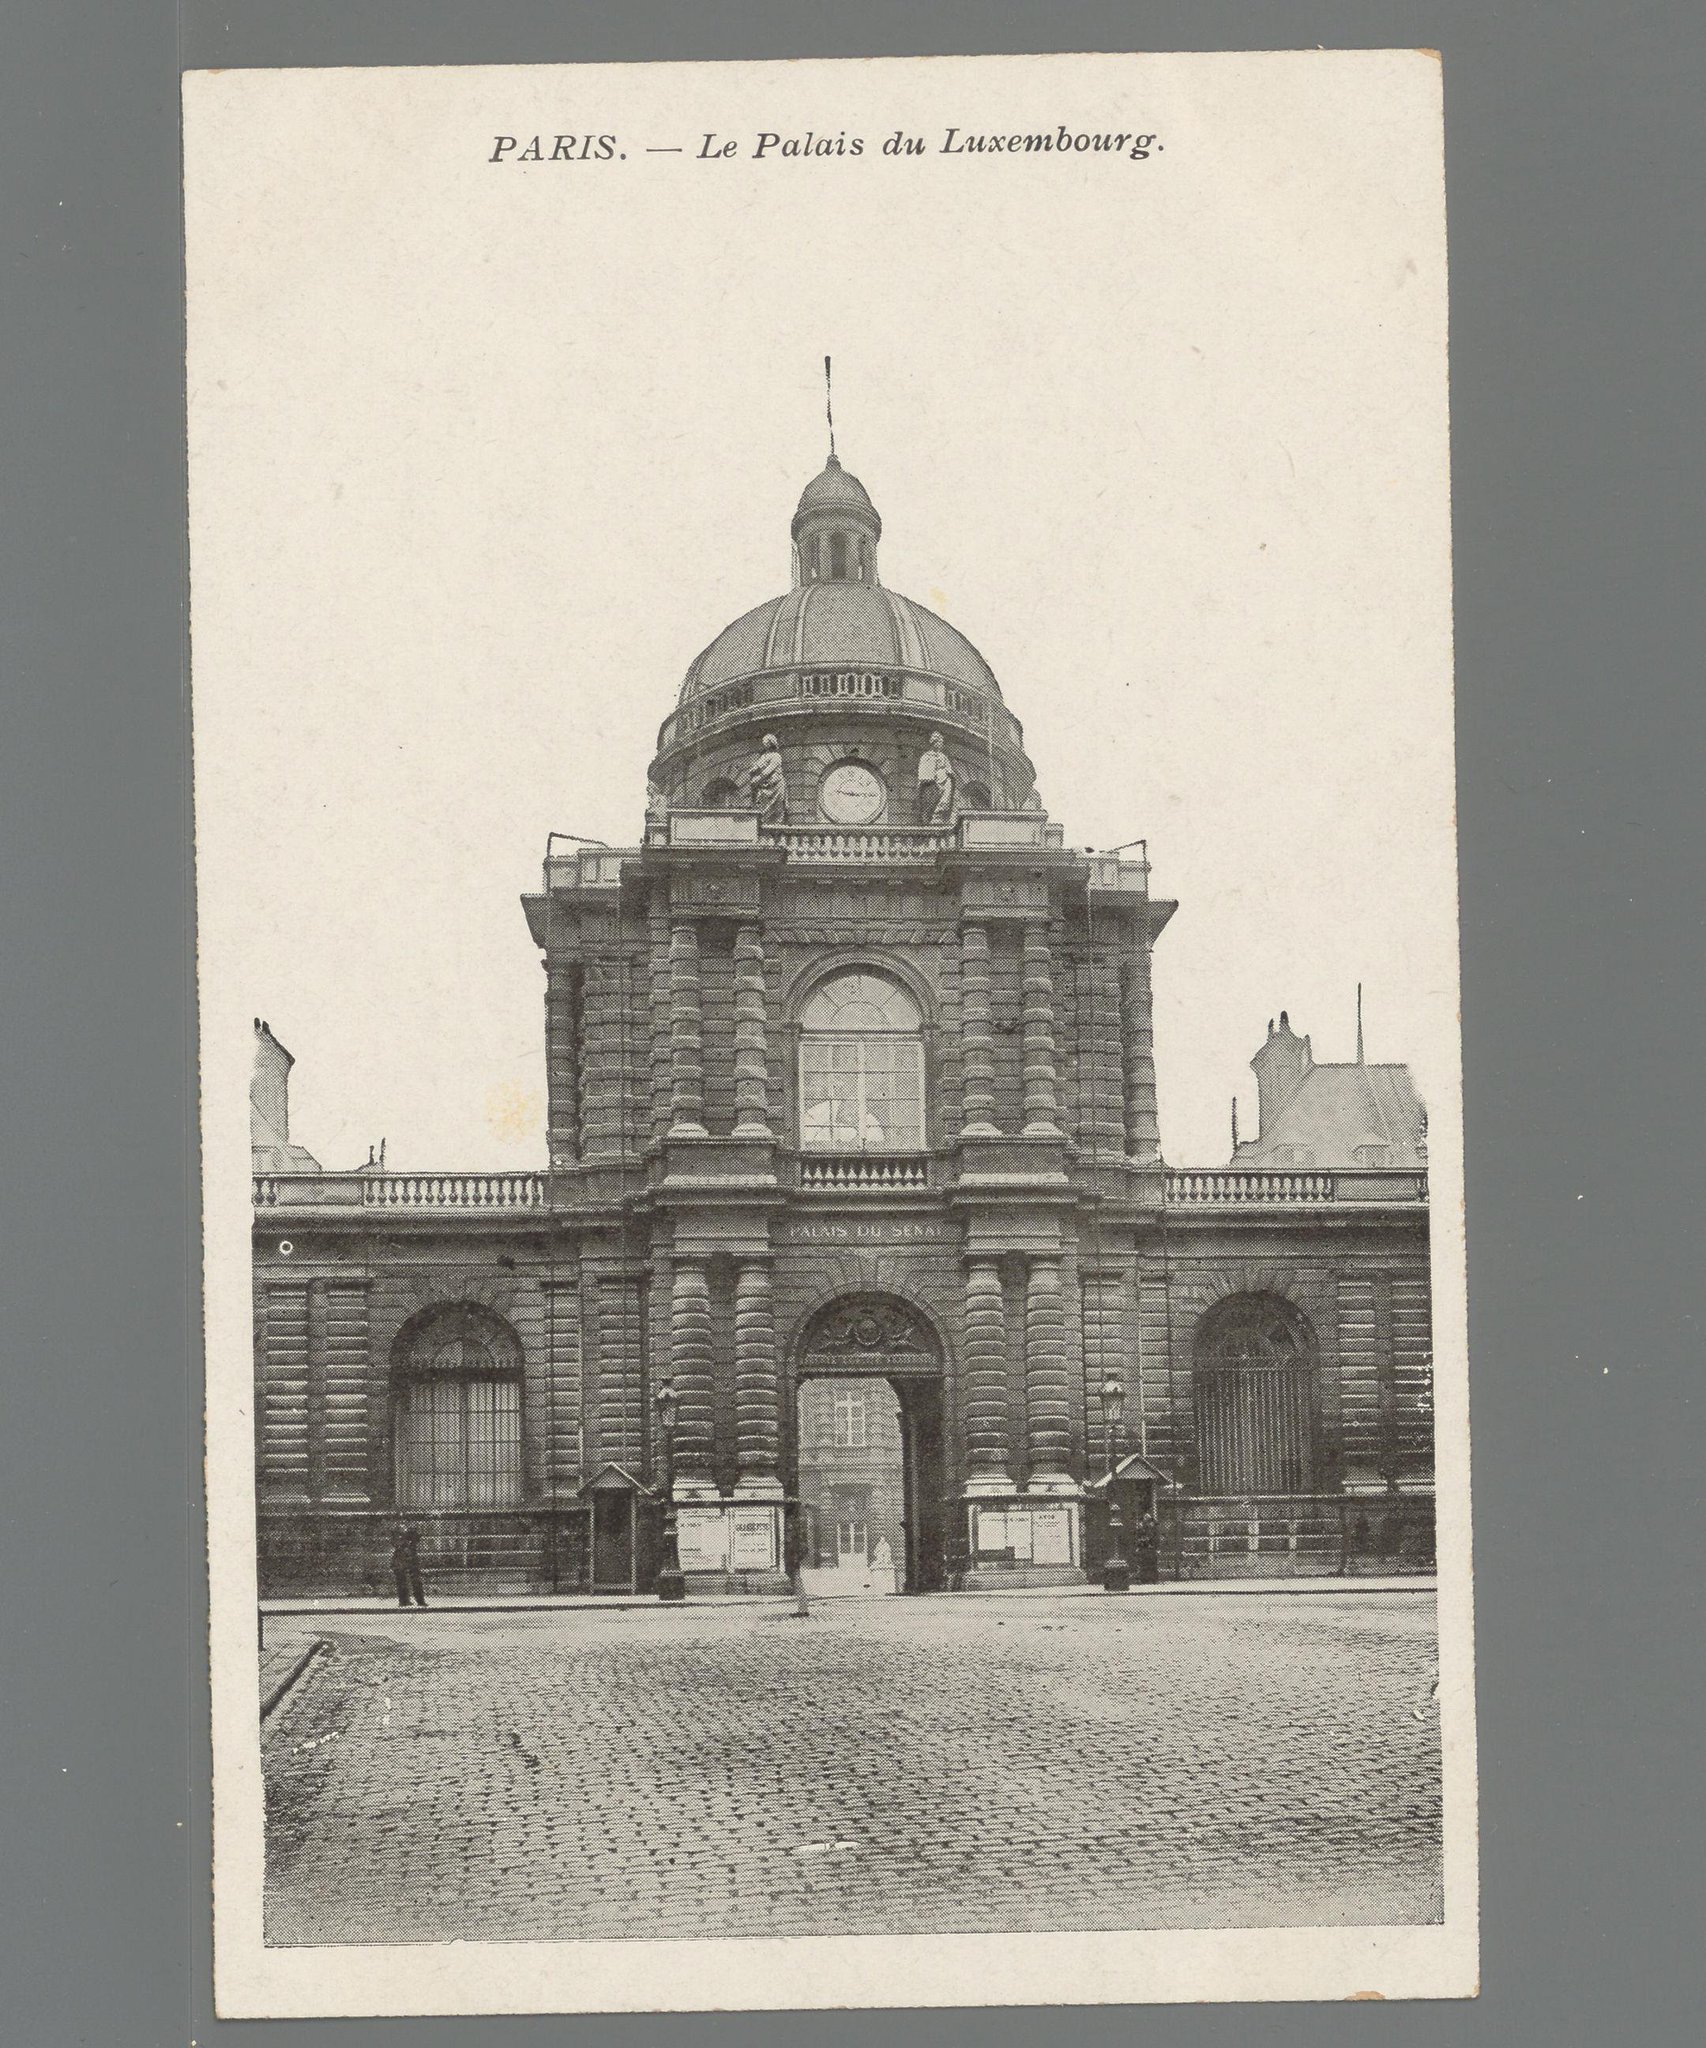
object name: photomechanical print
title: Paris. Le Palais du Luxembourg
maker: Anonymous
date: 1904-1906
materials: cardboard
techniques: autotype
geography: paris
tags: tower, clock tower ~ monumental adornment, palace, square, place, circus, etc. (+ city(-scape) with figures, staffage)